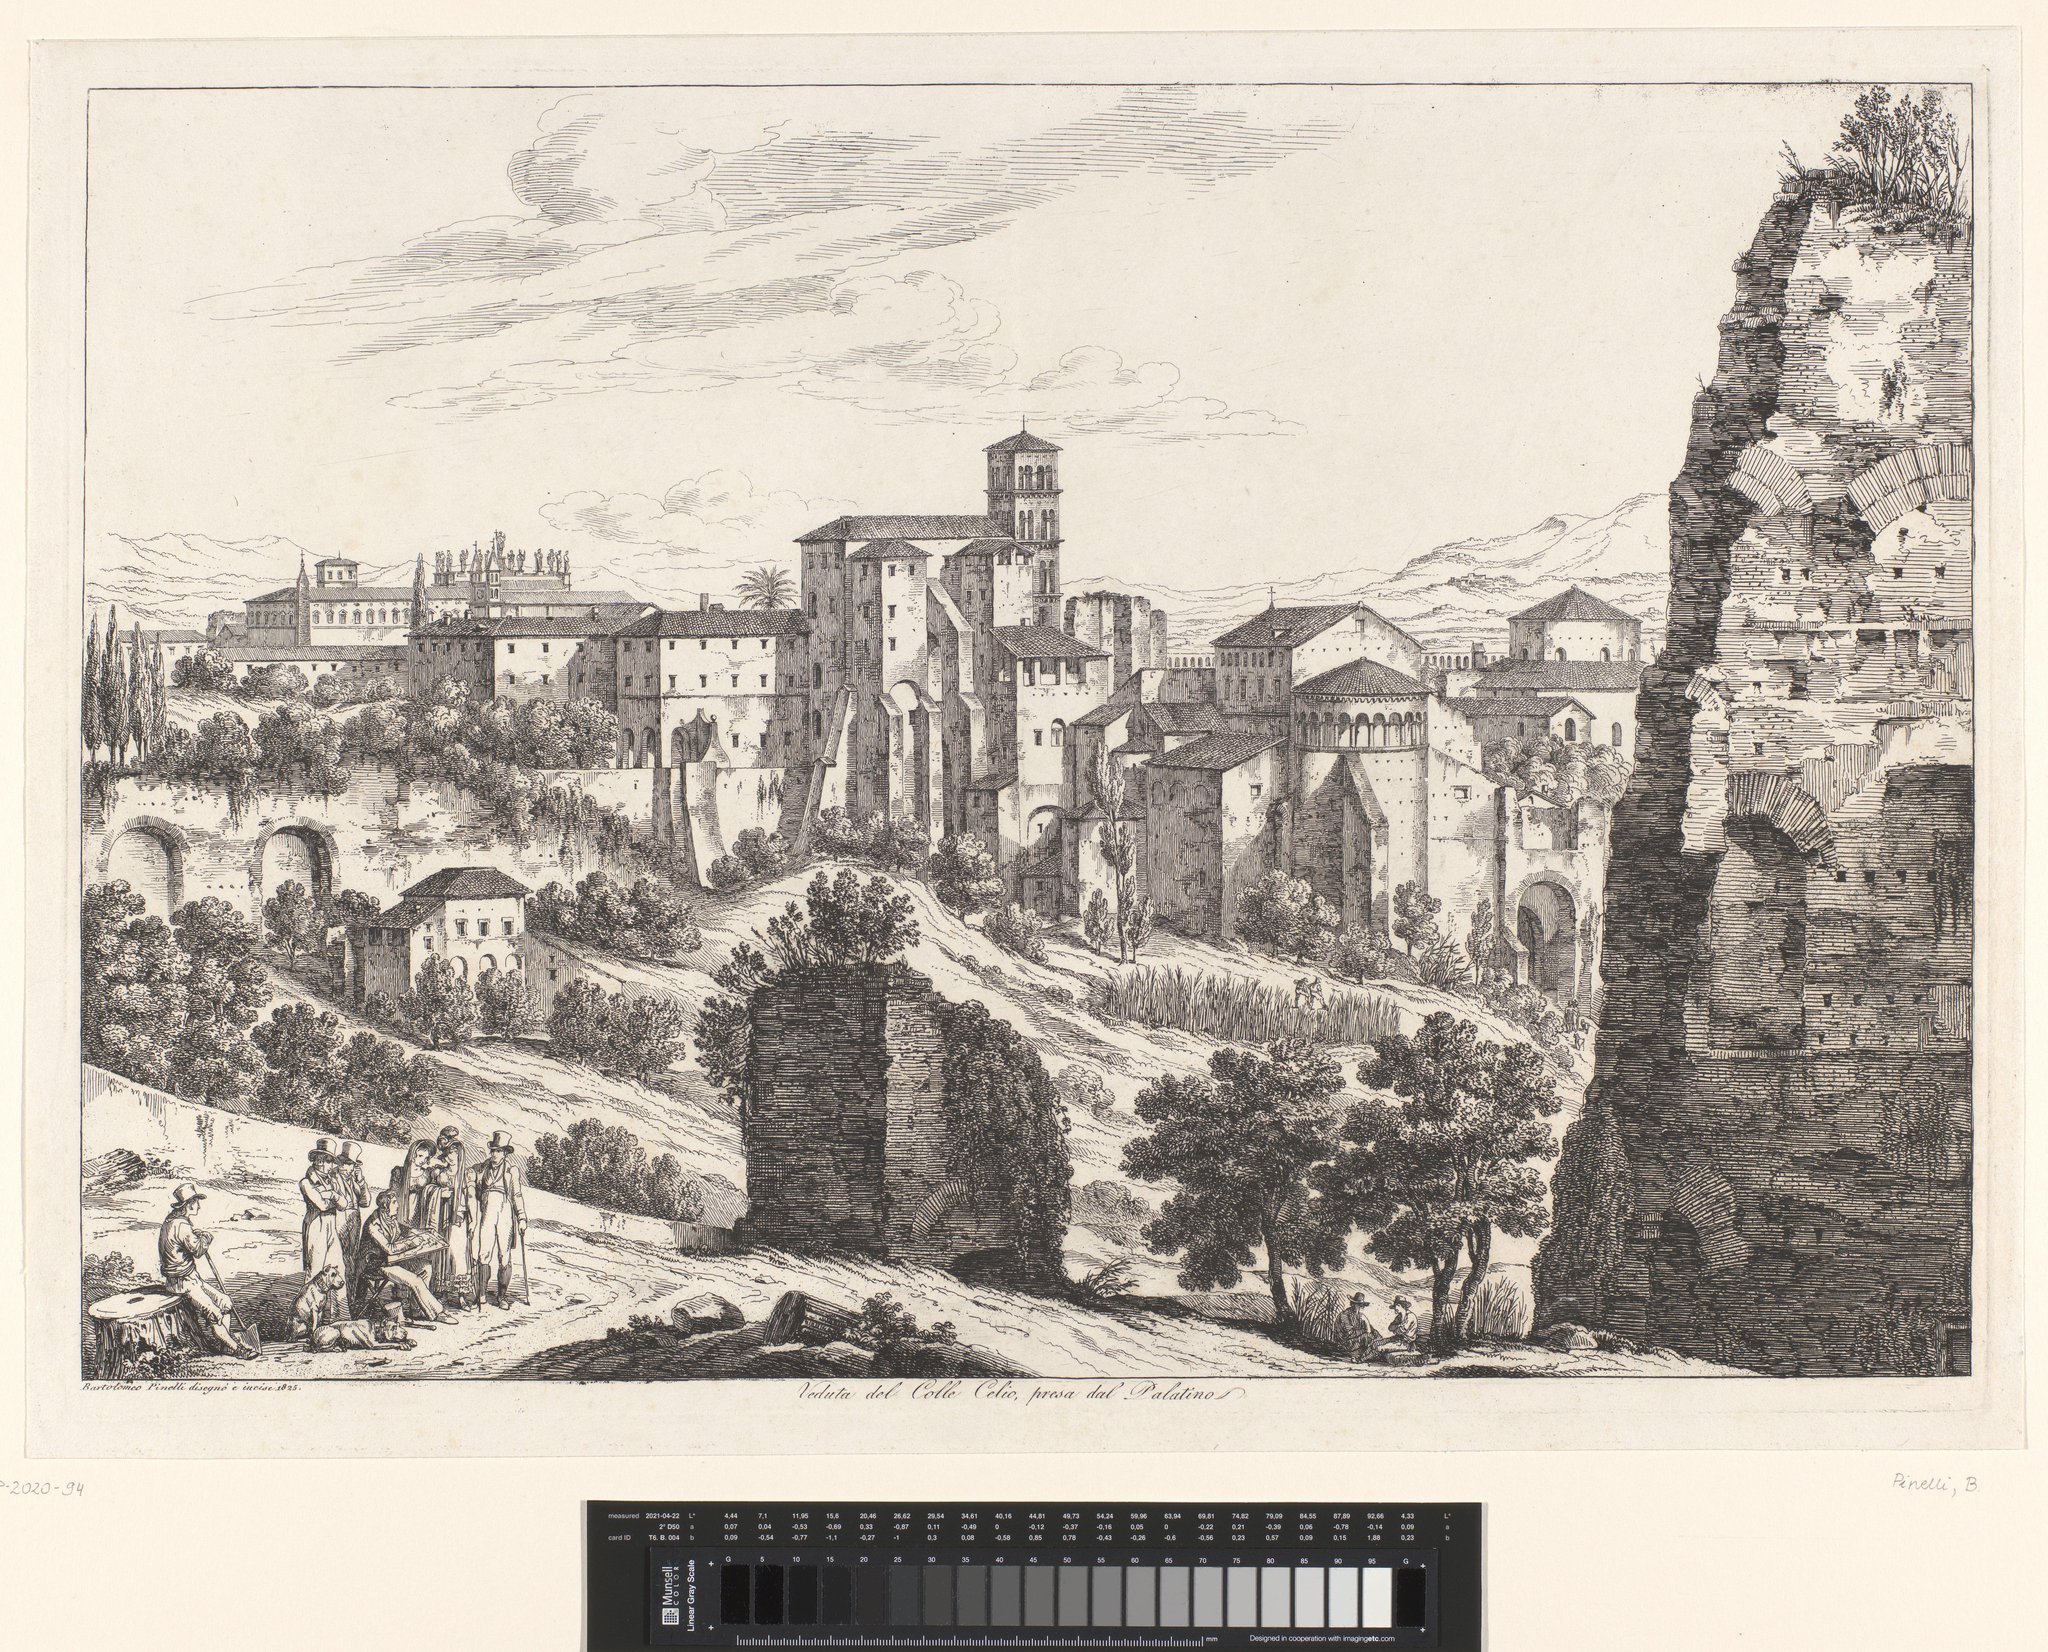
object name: print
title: Gezicht op de Colle Celio vanaf de Palatijn, met tekenende kunstenaar omringd door toeristen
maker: bartolomeo pinelli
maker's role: draughtsman, print maker, sculptor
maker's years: 1781-1835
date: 1825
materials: paper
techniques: etching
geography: rome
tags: ruin of a building ~ architecture, landscape with ruins, draughtsman studying classical remains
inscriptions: collector's mark: Lugt 2760, collector's mark: Lugt 2228